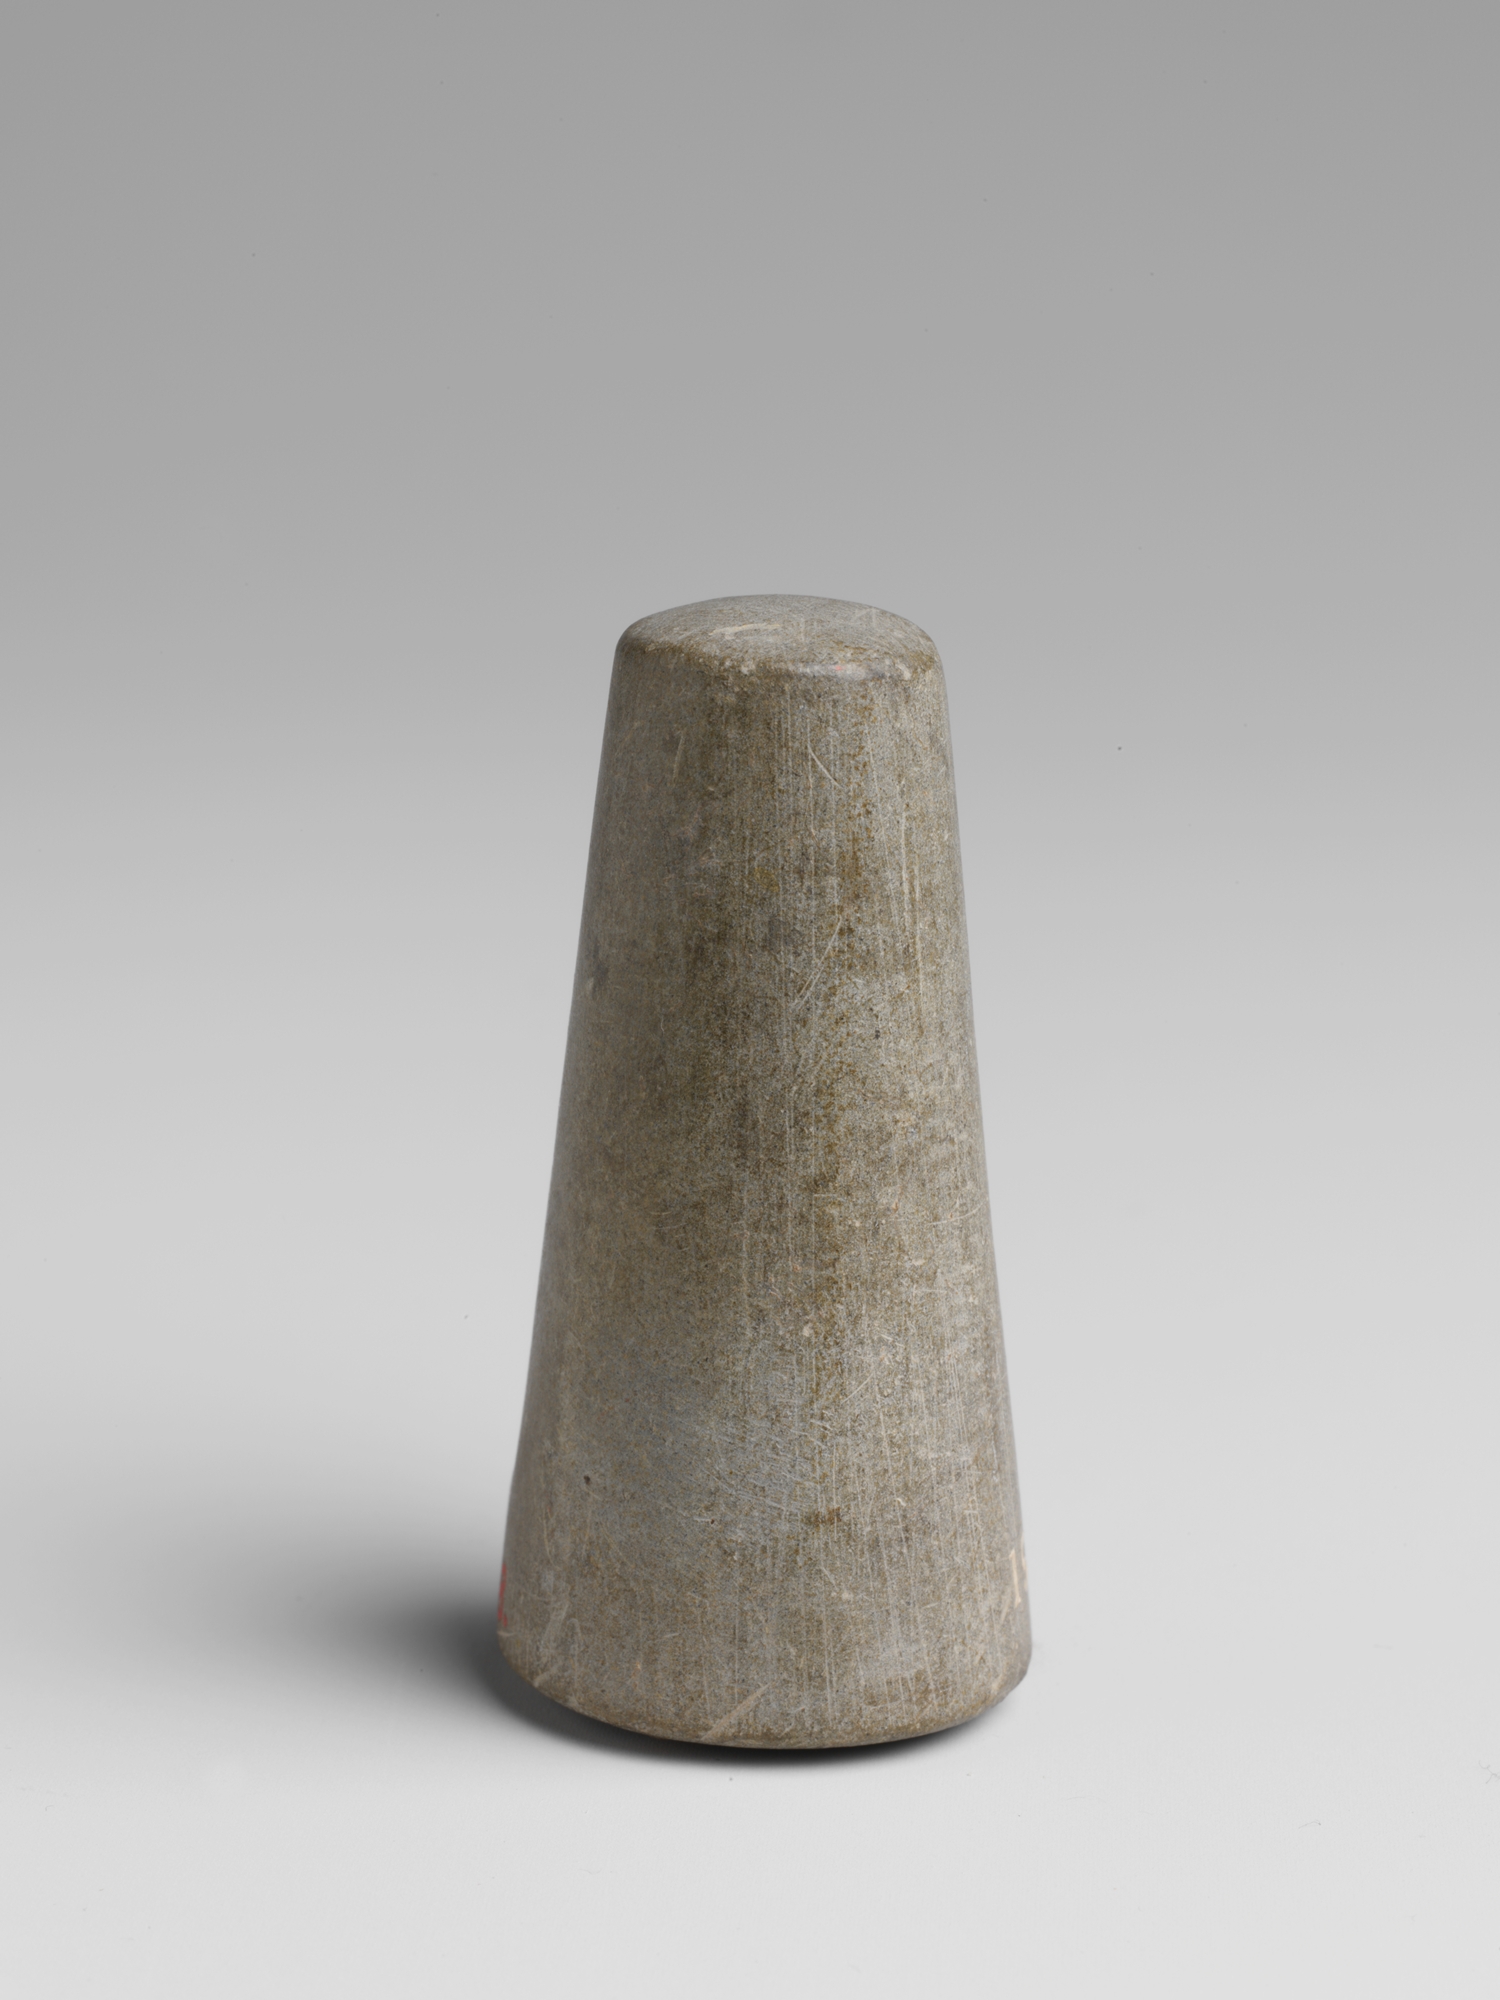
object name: pestle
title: Chlorite pestle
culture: cypriot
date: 1600-1050 BCE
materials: mineral